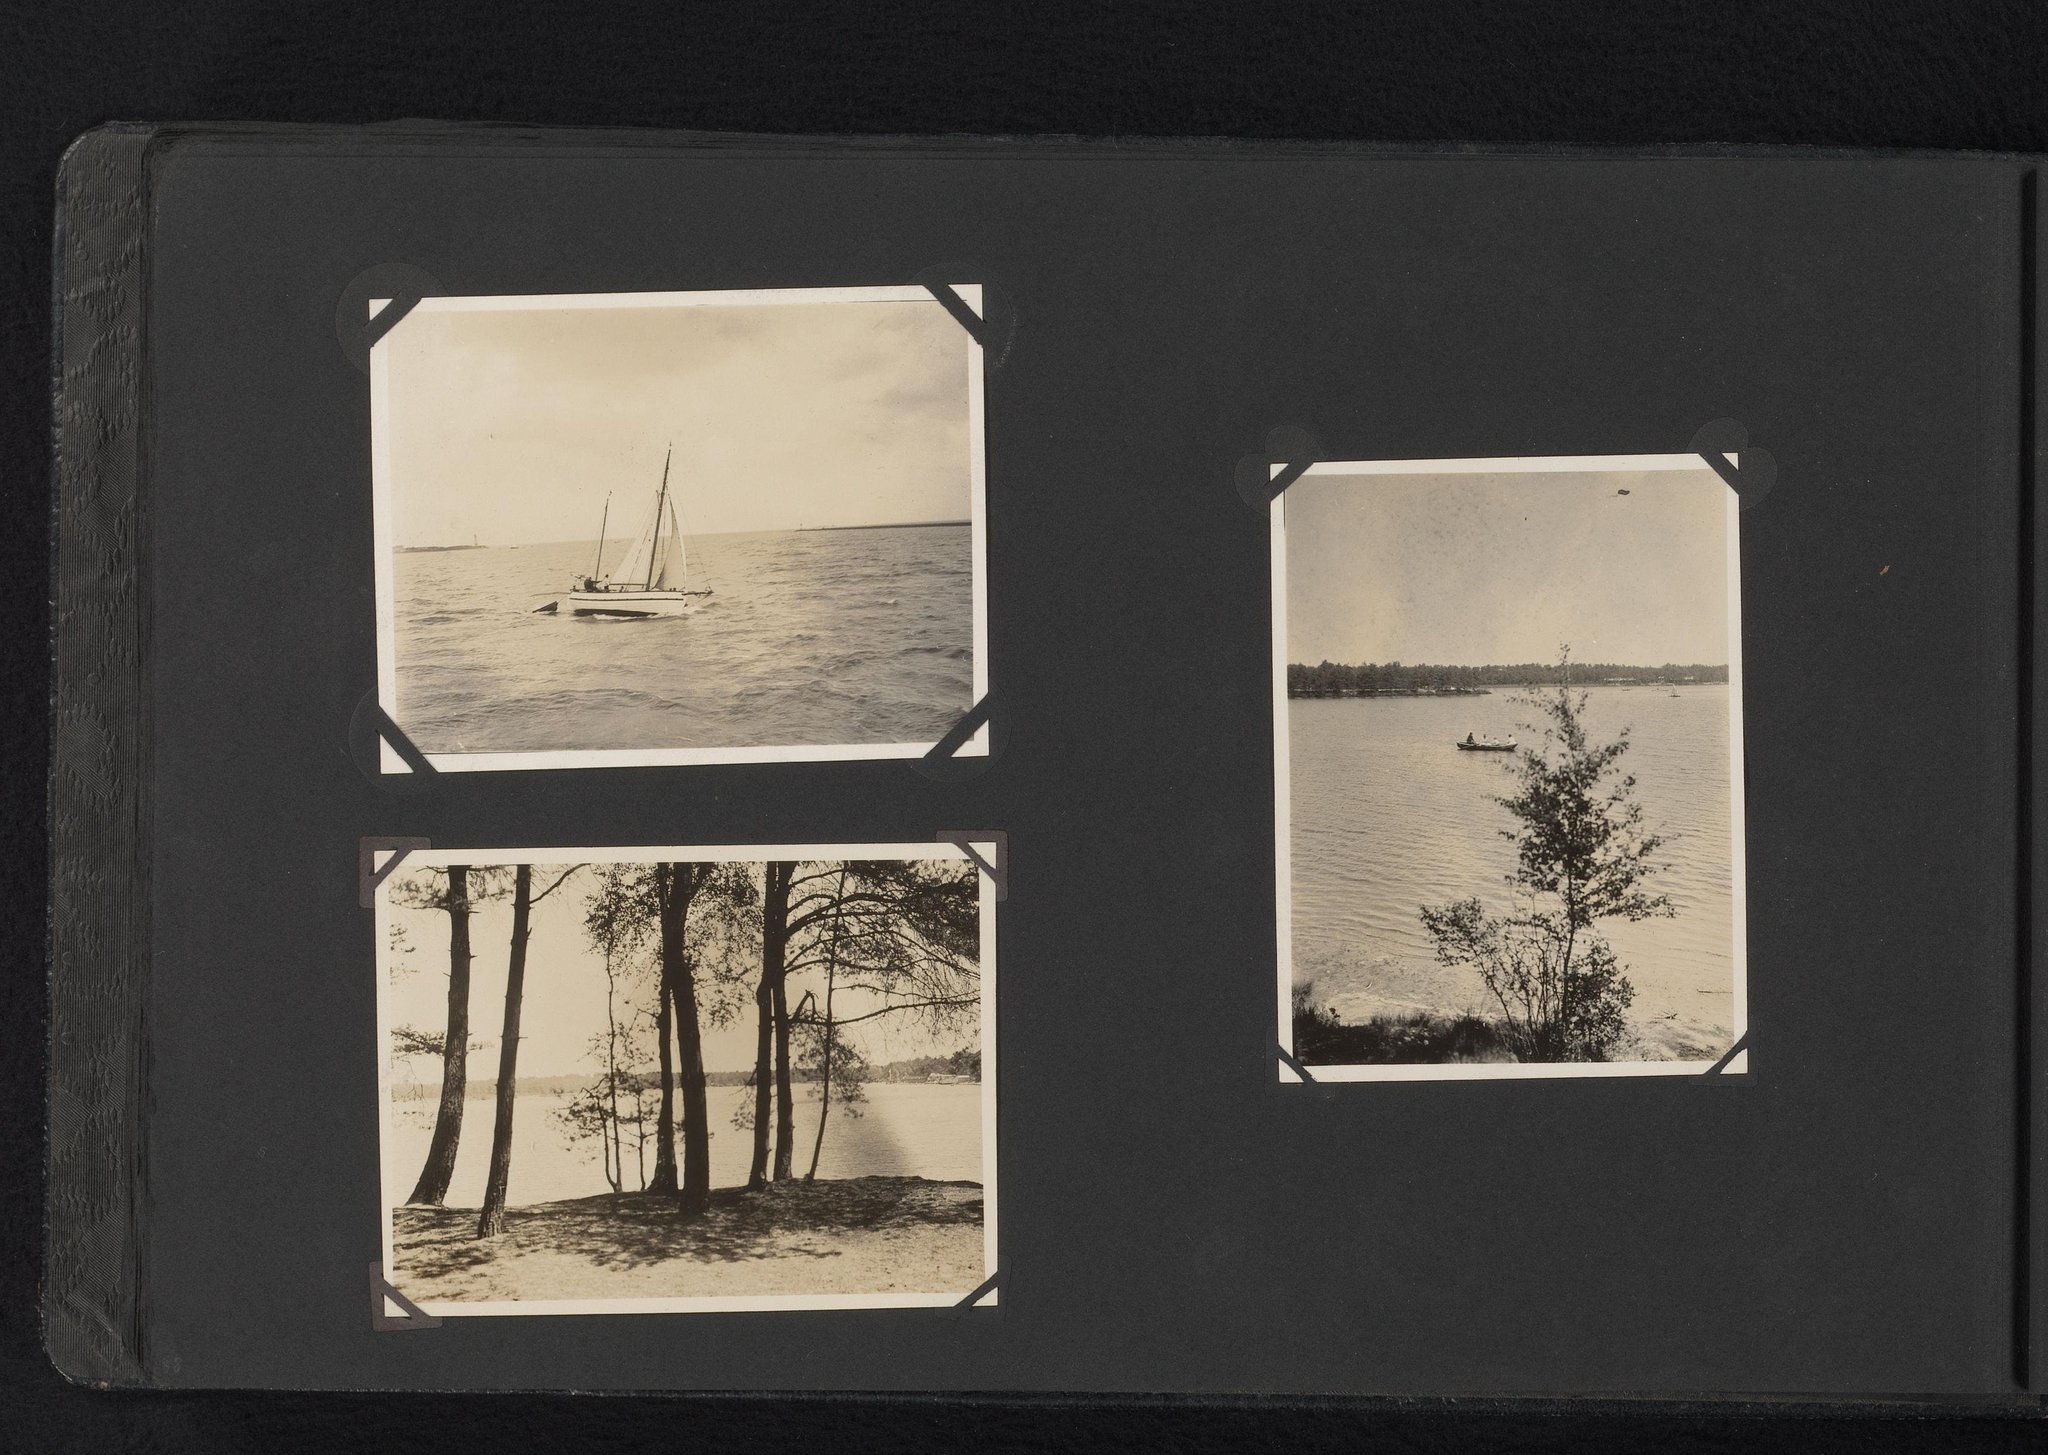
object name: album leaf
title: Vier foto's van zeilboten en een meer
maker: hendrik herman van den berg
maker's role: amateurfotograaf, jurist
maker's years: 1875-1944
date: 1932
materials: paper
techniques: gelatin silver print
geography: netherlands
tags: sailing-ship, sailing-boat, lake, netherlands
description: Deze foto's maken deel uit van een album.